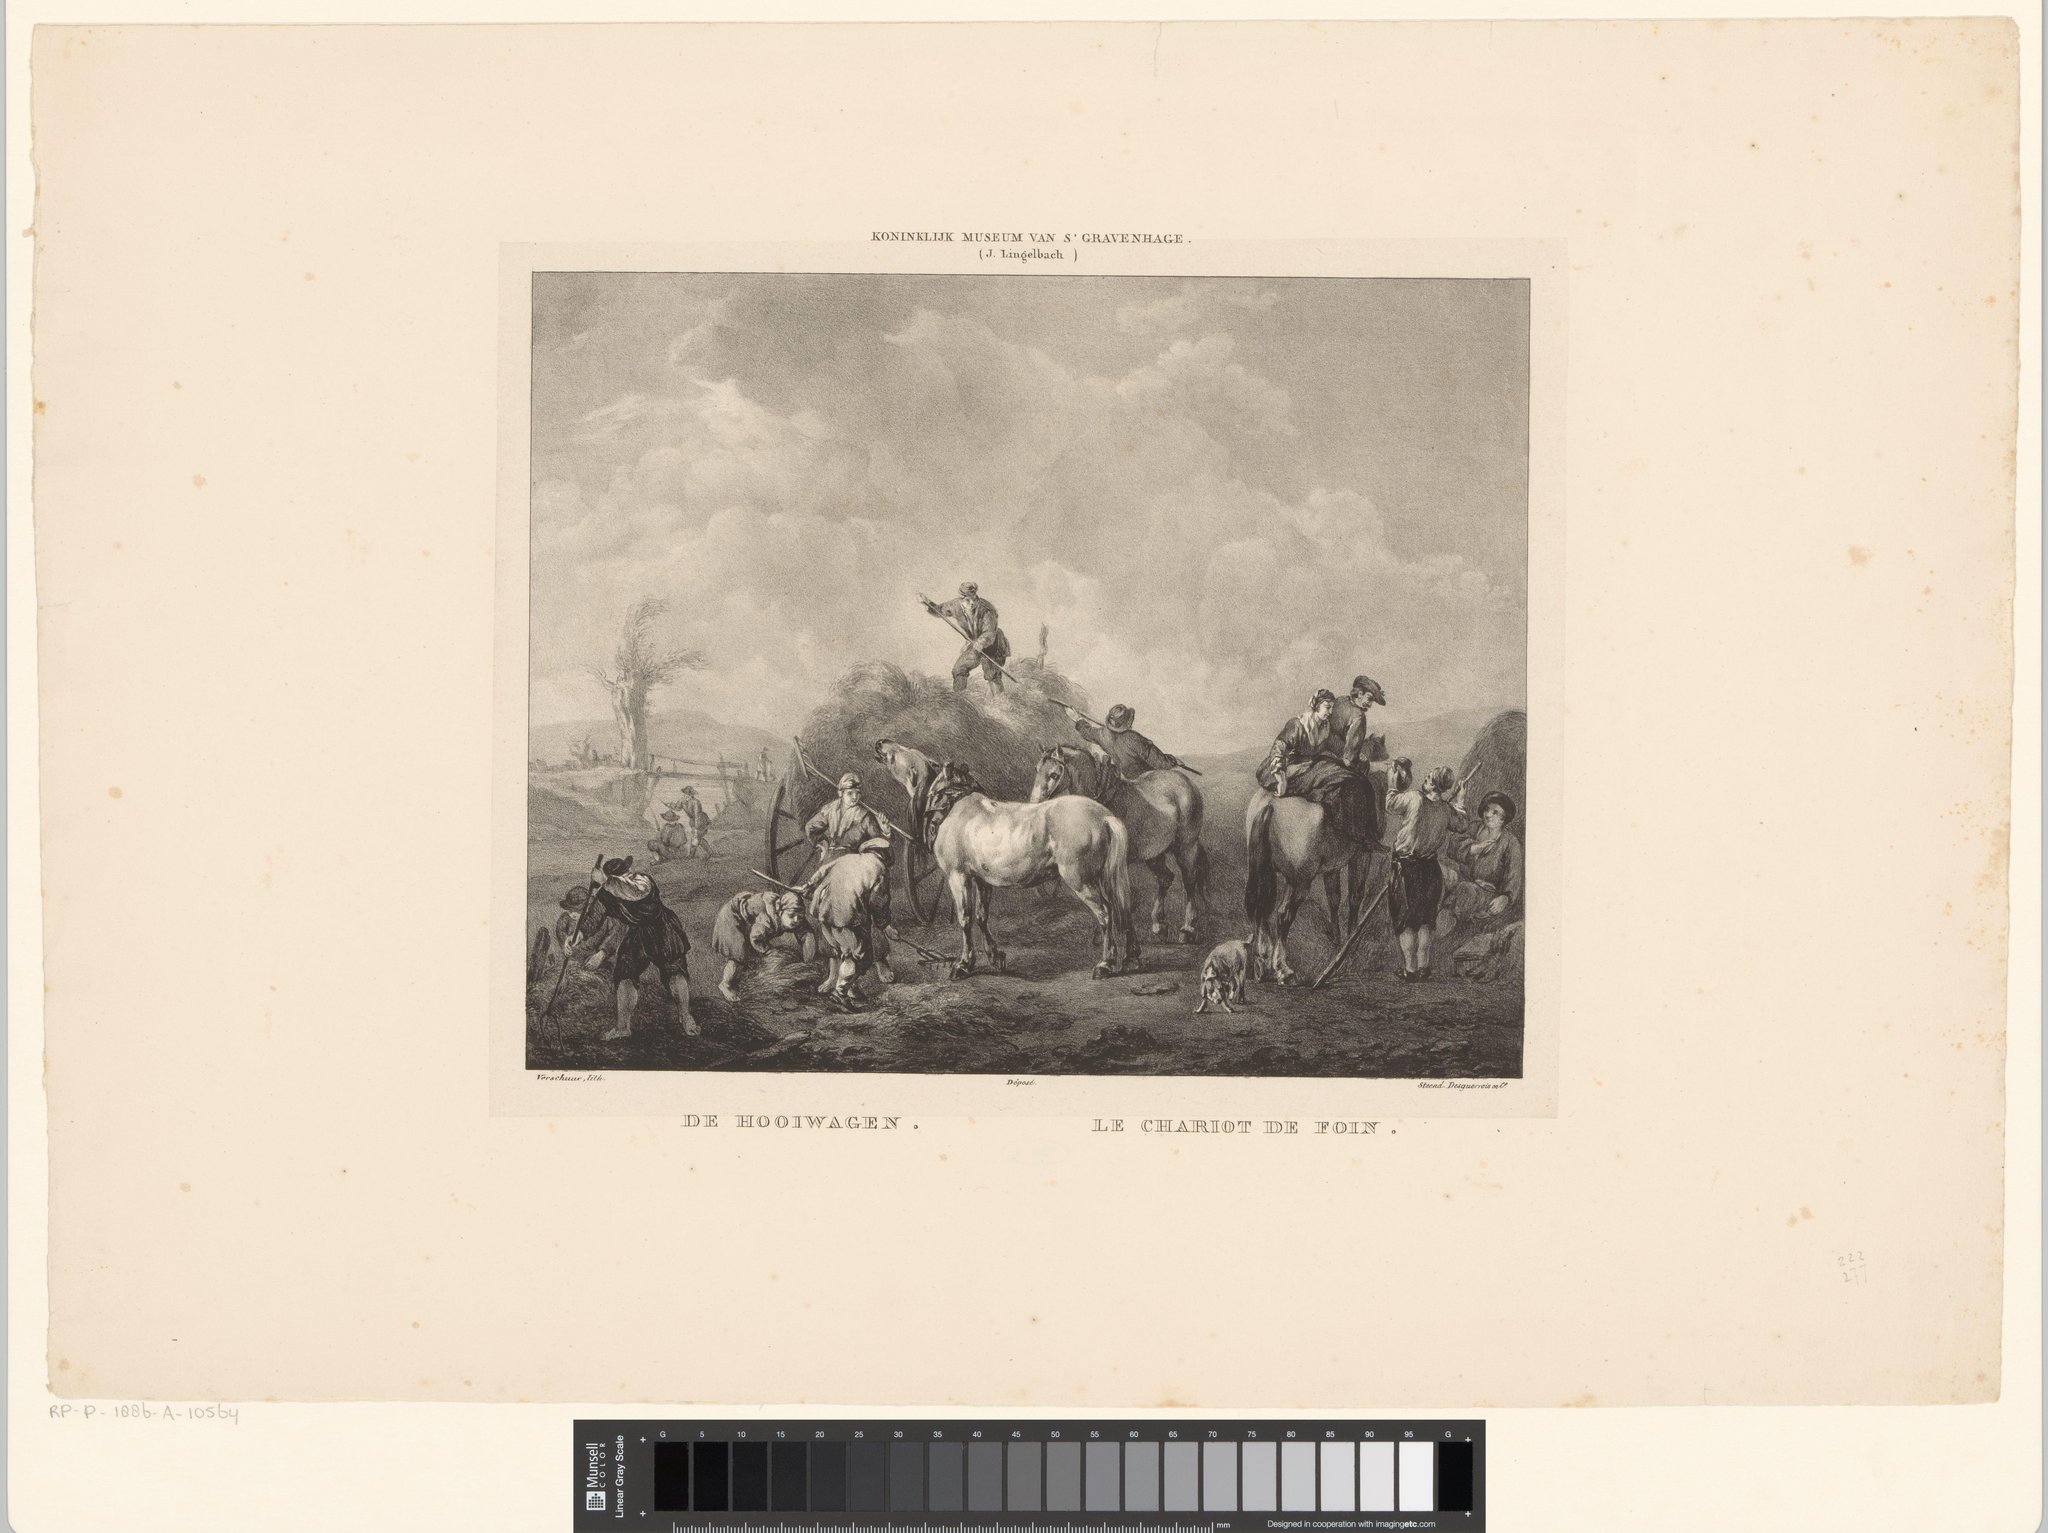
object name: print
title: De hooiwagen / Le chariot de foin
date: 1831-1832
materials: paper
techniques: lithograph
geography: netherlands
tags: hay-wagon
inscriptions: collector's mark: Lugt 2228, : ‘Déposé.’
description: Naar De Hooioogst van Johannes Lingelbach in de collectie van het Mauritshuis te Den Haag. Inventarisnummer 87.